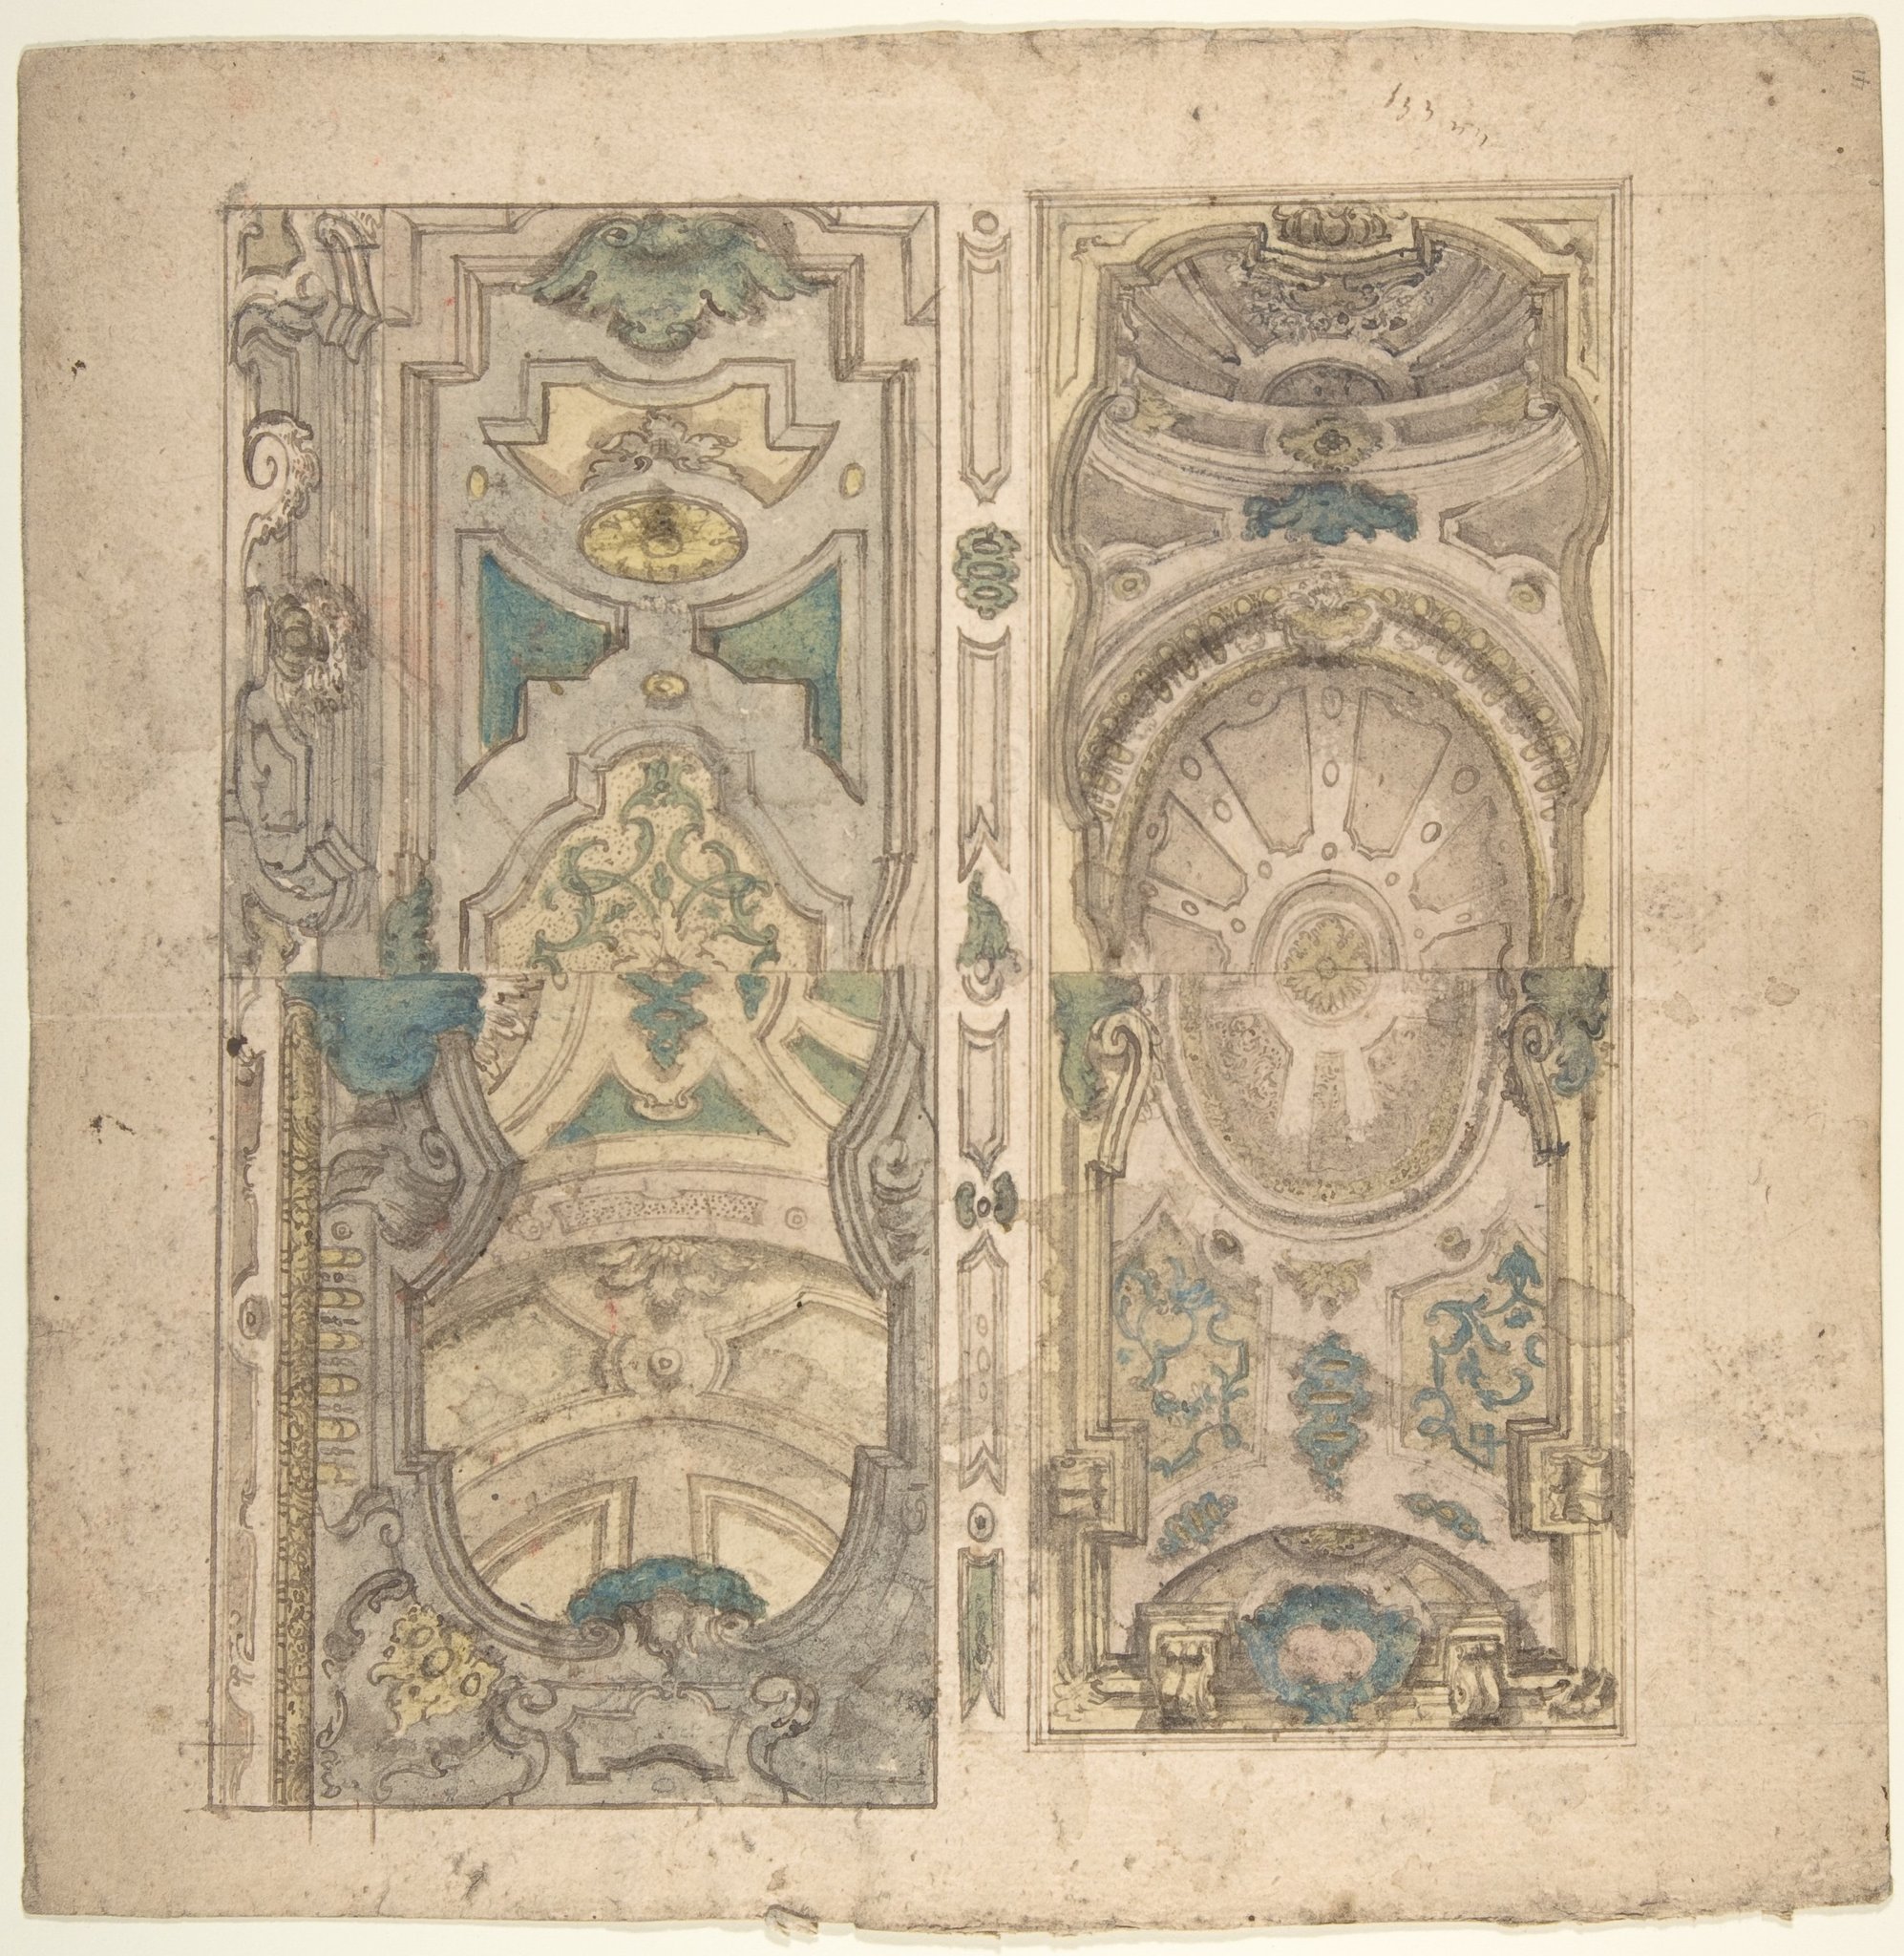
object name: drawing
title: Four Alternate Designs for a Vault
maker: anonymous, italian, piedmontese, 18th century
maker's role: artist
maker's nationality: italian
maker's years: 1700-1800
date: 1700-1780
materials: chalk, graphite, ink, drawing material, watercolor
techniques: brush, pen, wash